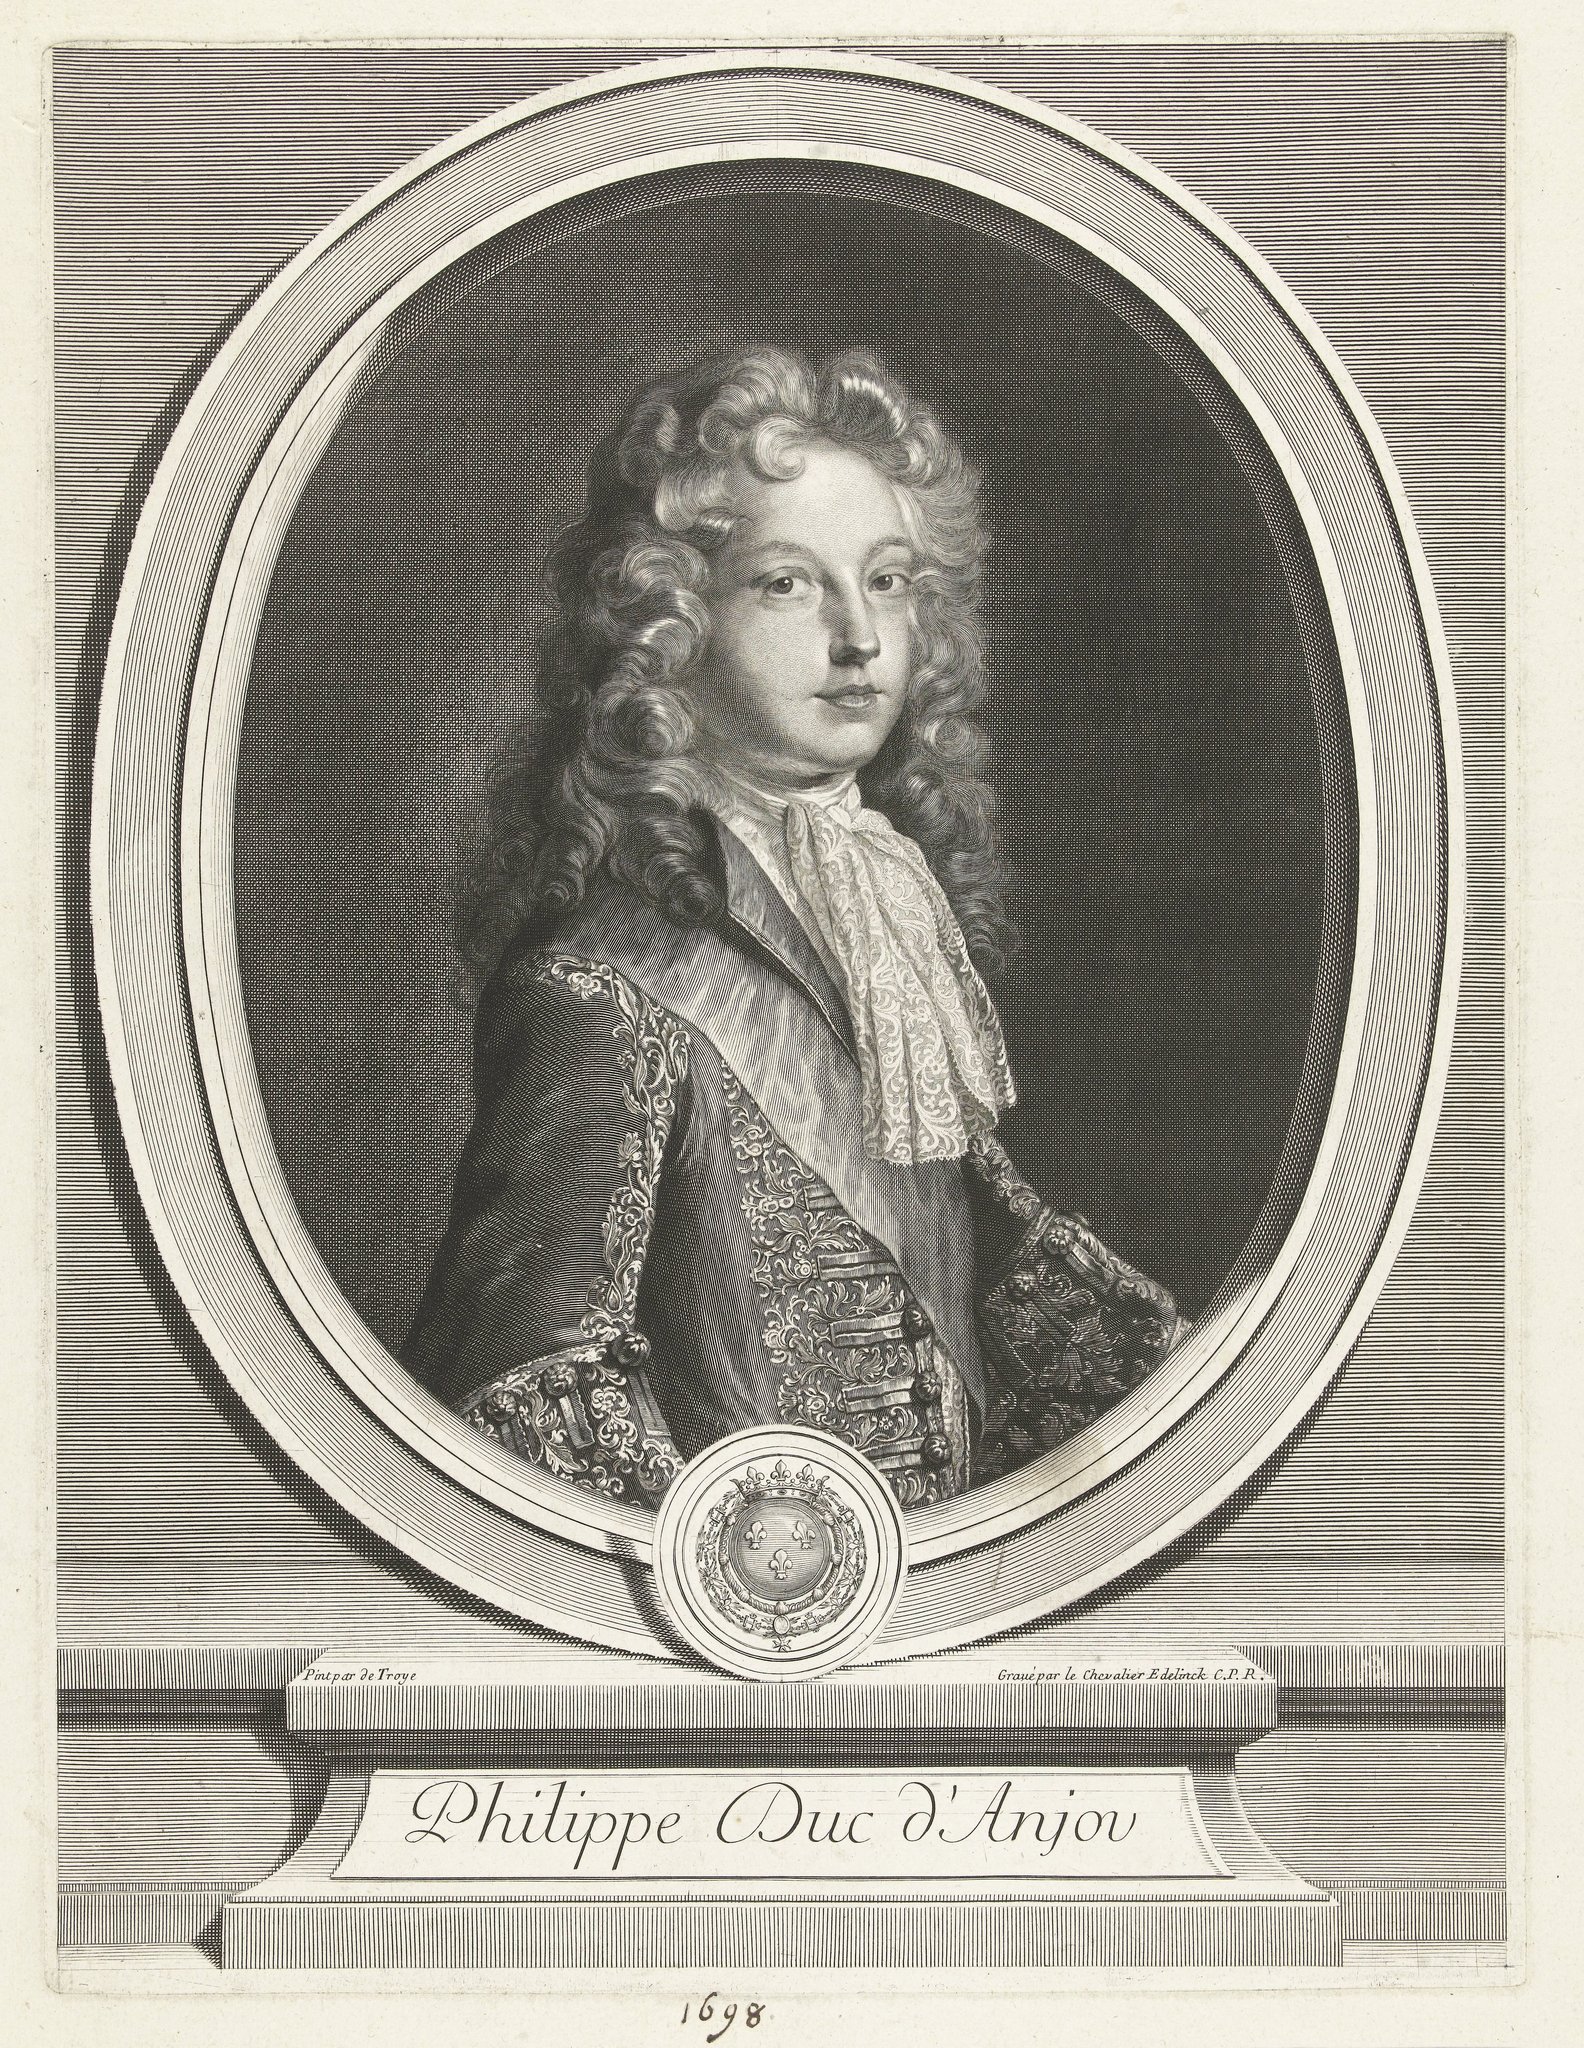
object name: print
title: Portret van Filips V van Spanje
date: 1698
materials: paper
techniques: engraving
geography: france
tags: filips v (koning van spanje)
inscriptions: collector's mark: Lugt 240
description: Portret van de jonge hertog Filips van Anjou (1683-1746), vanaf 1700 koning Filips V van Spanje. Afgebeeld in ovale omlijsting met wapen.